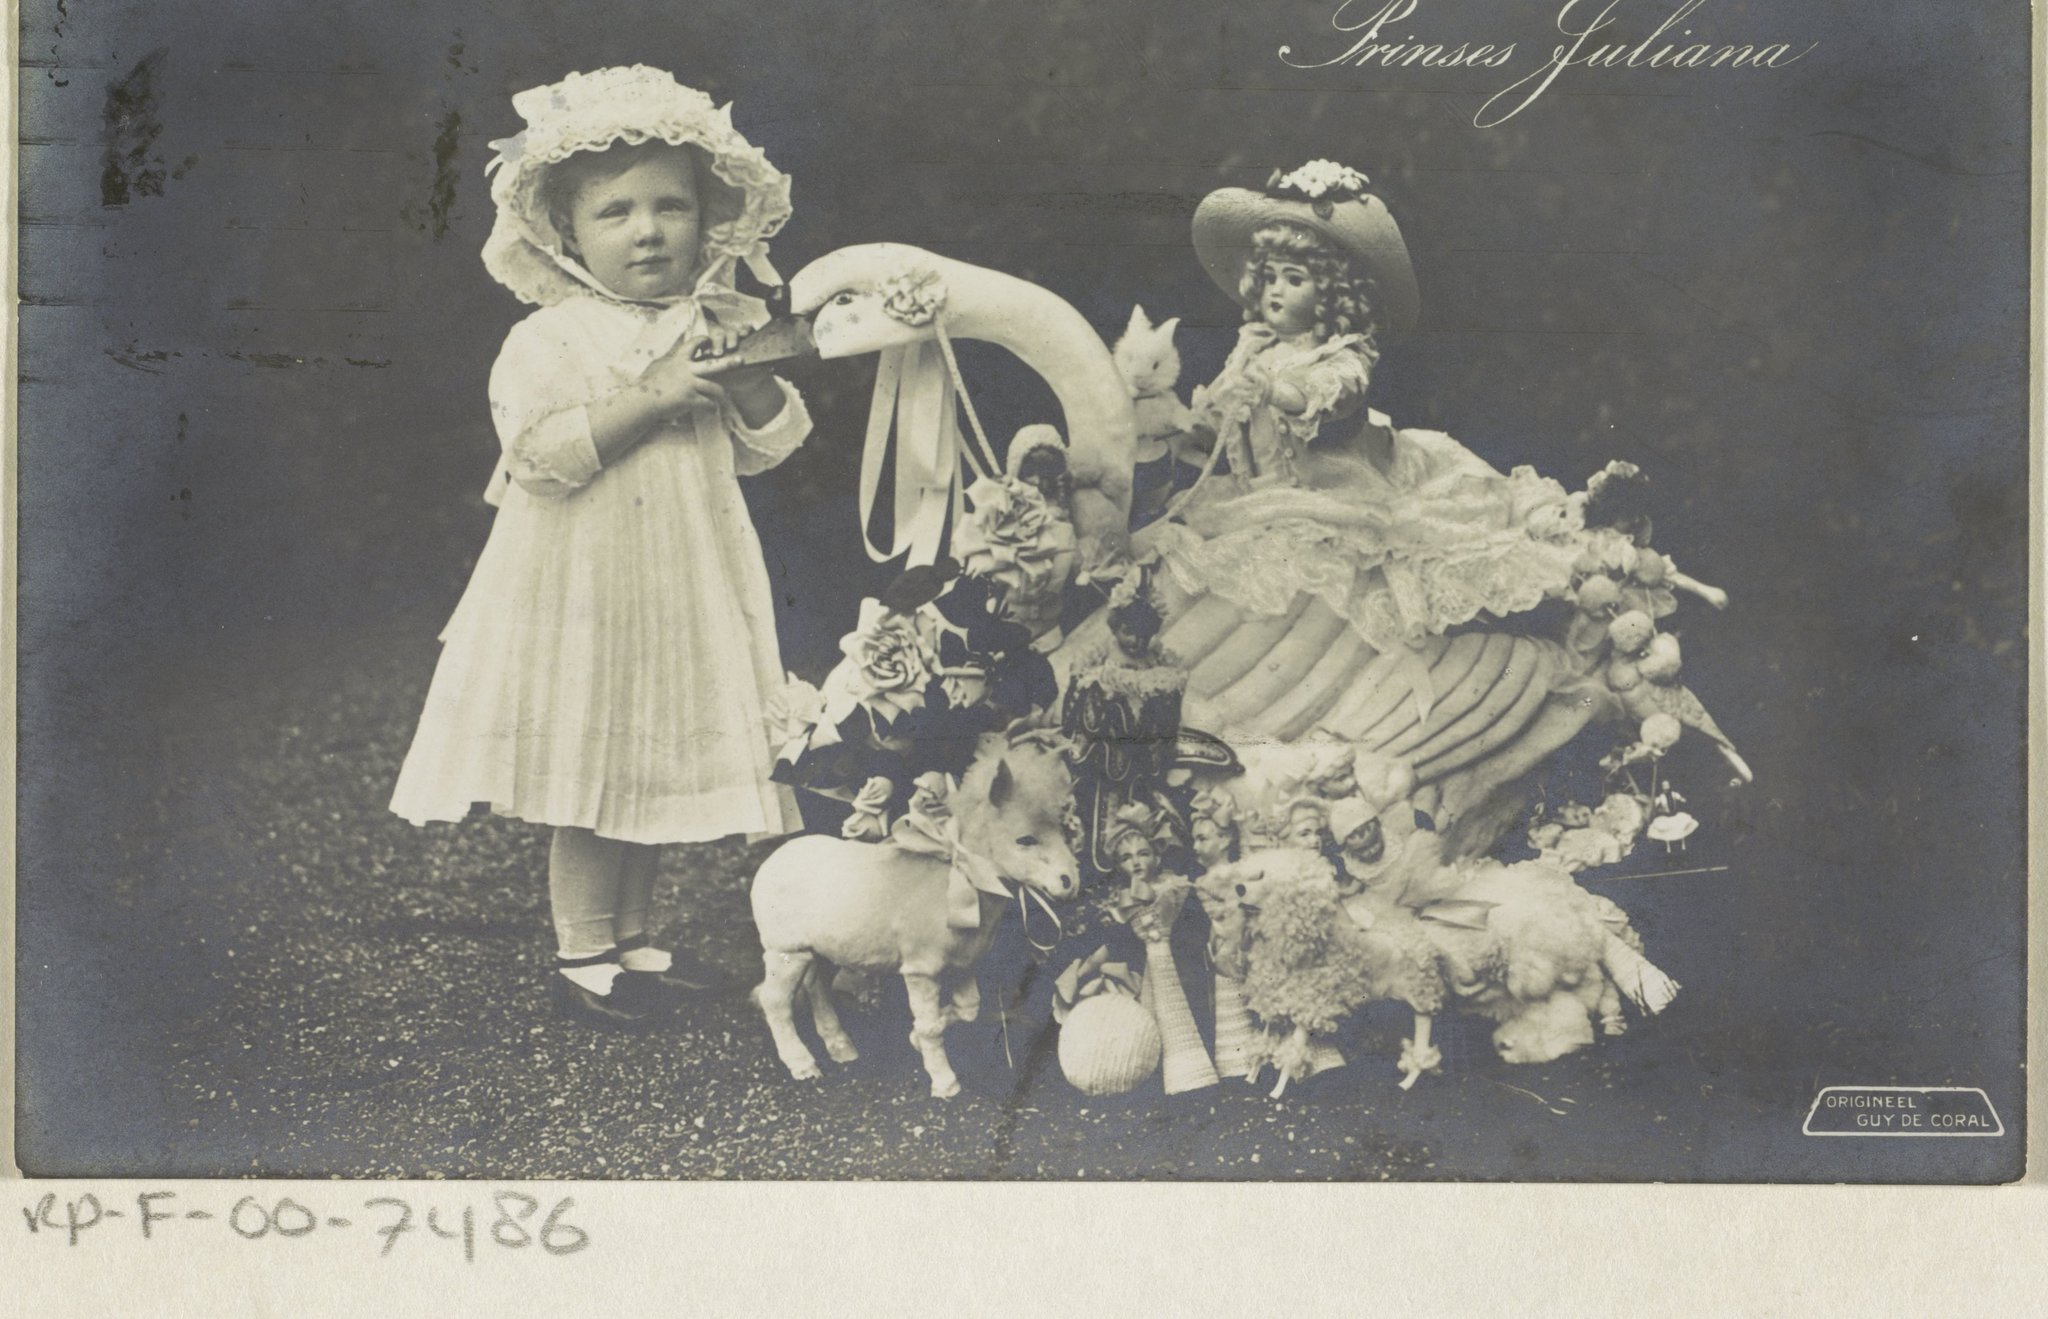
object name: ansichtkaart, prentbriefkaart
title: Portret van Juliana, koningin der Nederlanden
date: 1911-1912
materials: photographic support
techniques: photography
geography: the hague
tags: juliana of the netherlands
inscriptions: inscription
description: De hier vermelde titel verwijst naar de hoogst verkregen titel van de geportretteerde, niet per se naar de titel die de geportretteerde op deze voorstelling draagt.